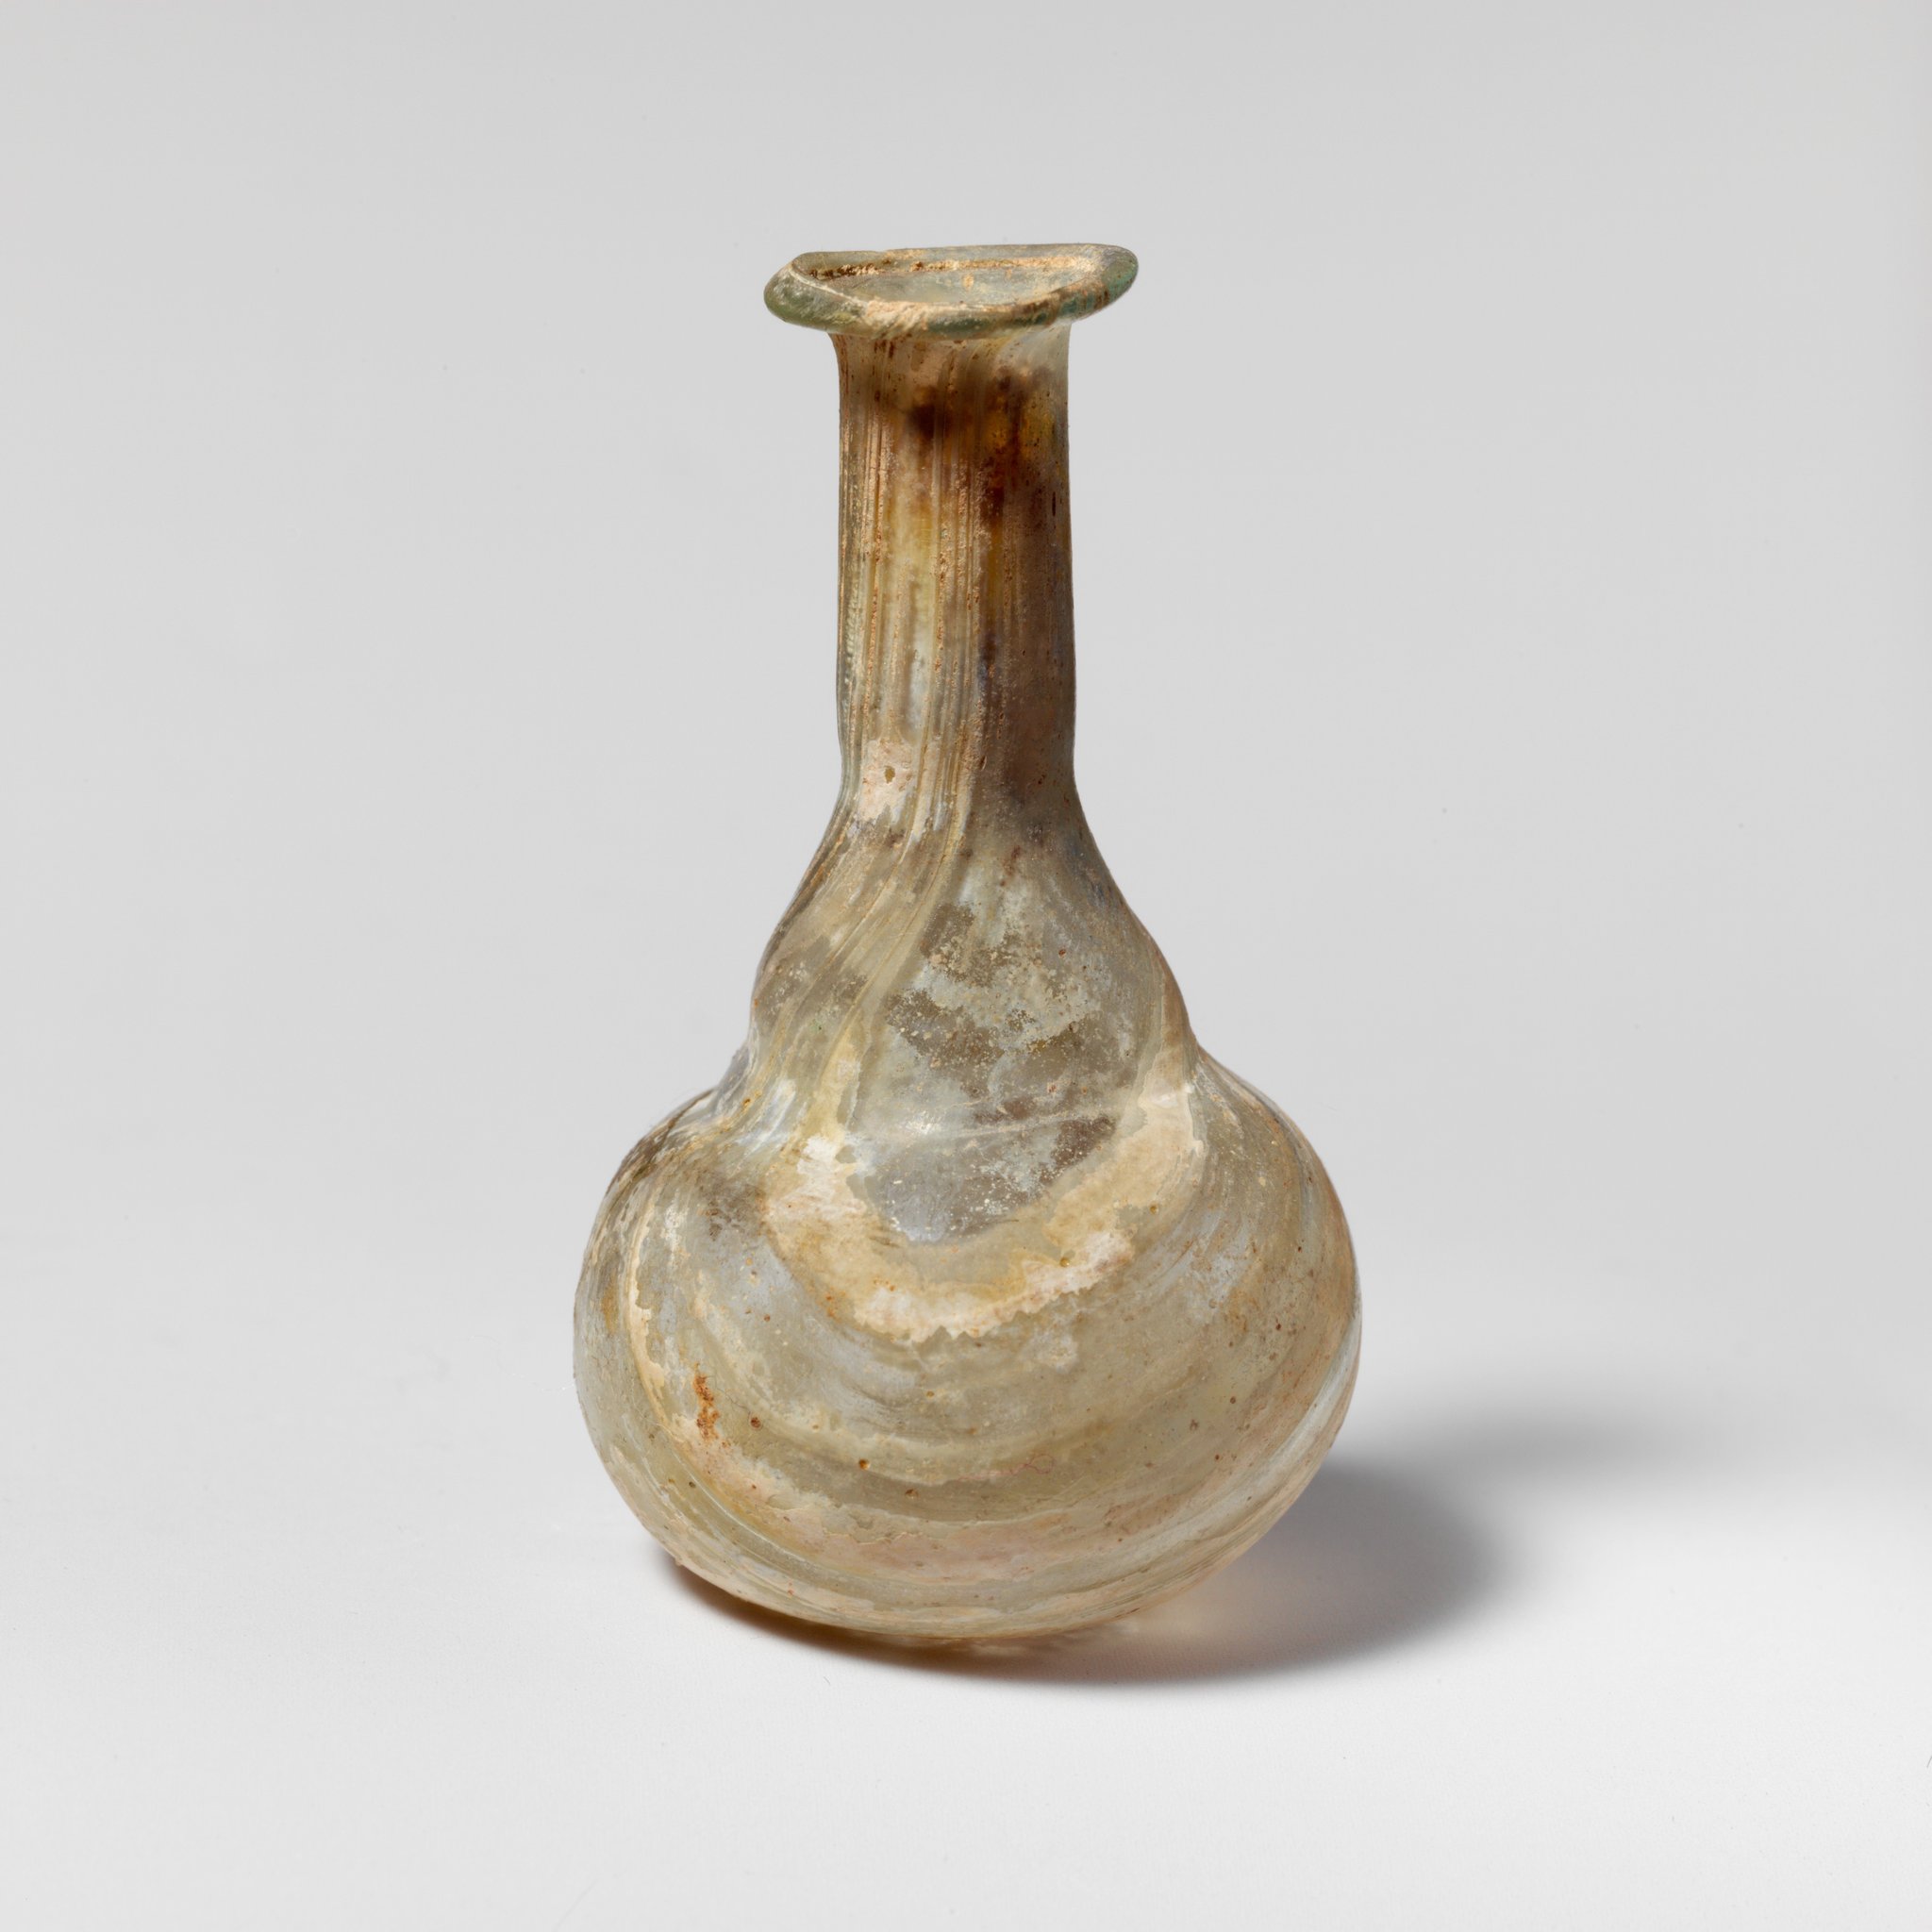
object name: perfume bottle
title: Glass perfume bottle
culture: roman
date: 1-100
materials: glass